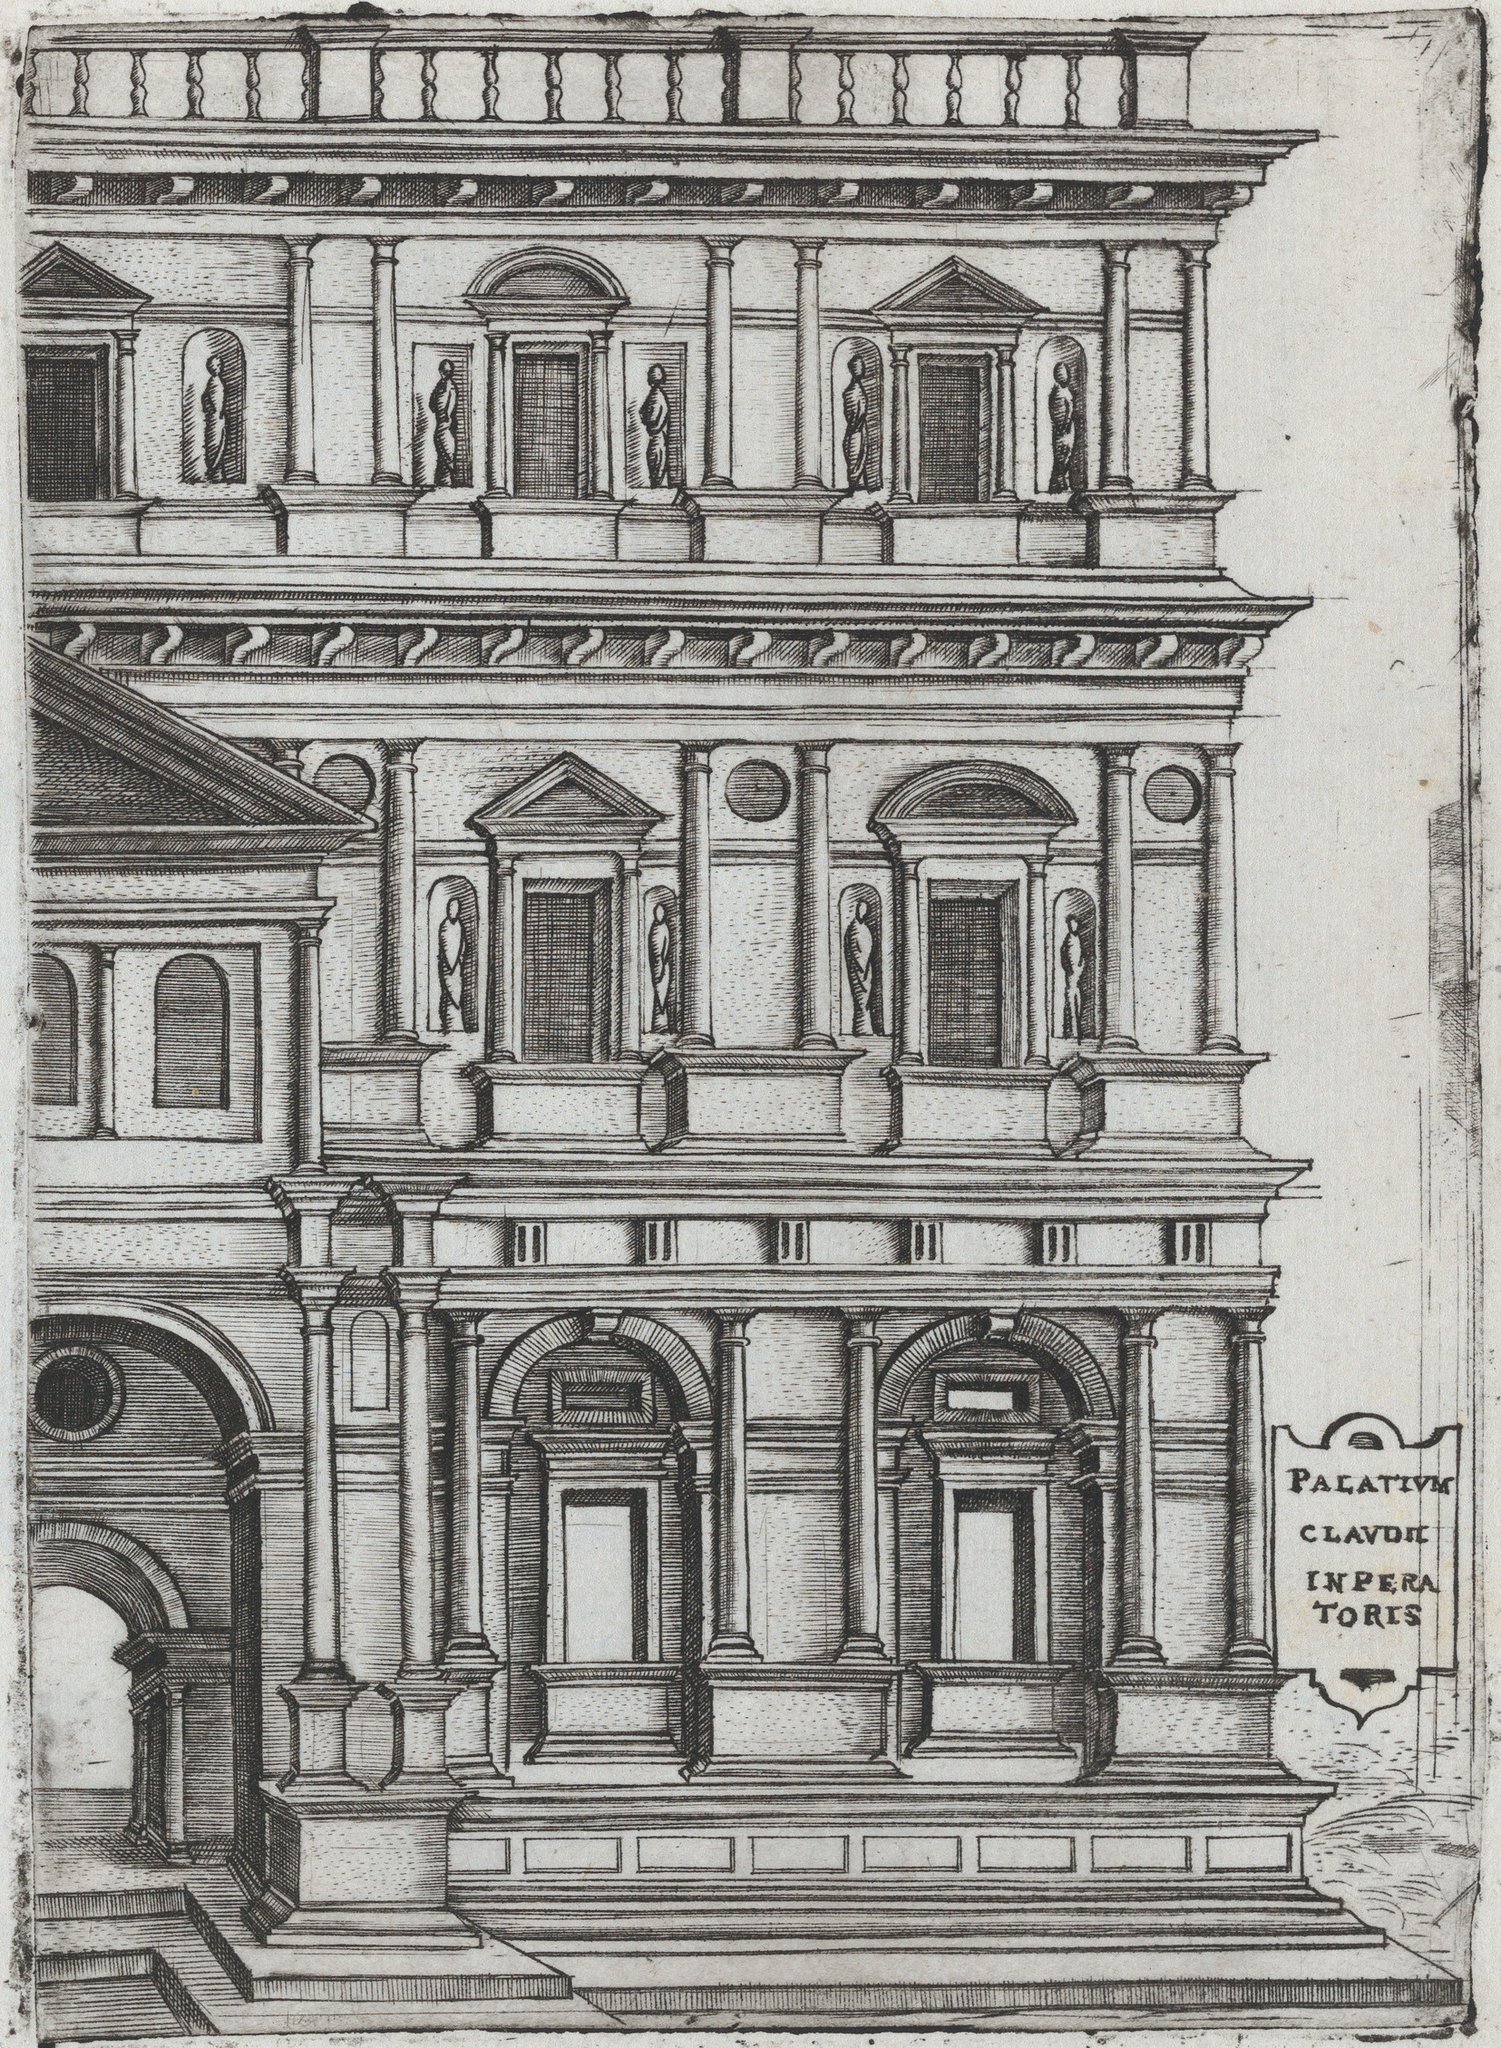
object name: album print ornament architecture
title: Aerarii Publici Rome, from a Series of Prints depicting (reconstructed) Buildings from Roman Antiquity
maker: monogrammist g.a. with the caltrop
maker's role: artist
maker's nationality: italian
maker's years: 1535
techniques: engraving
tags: architecture,buildings